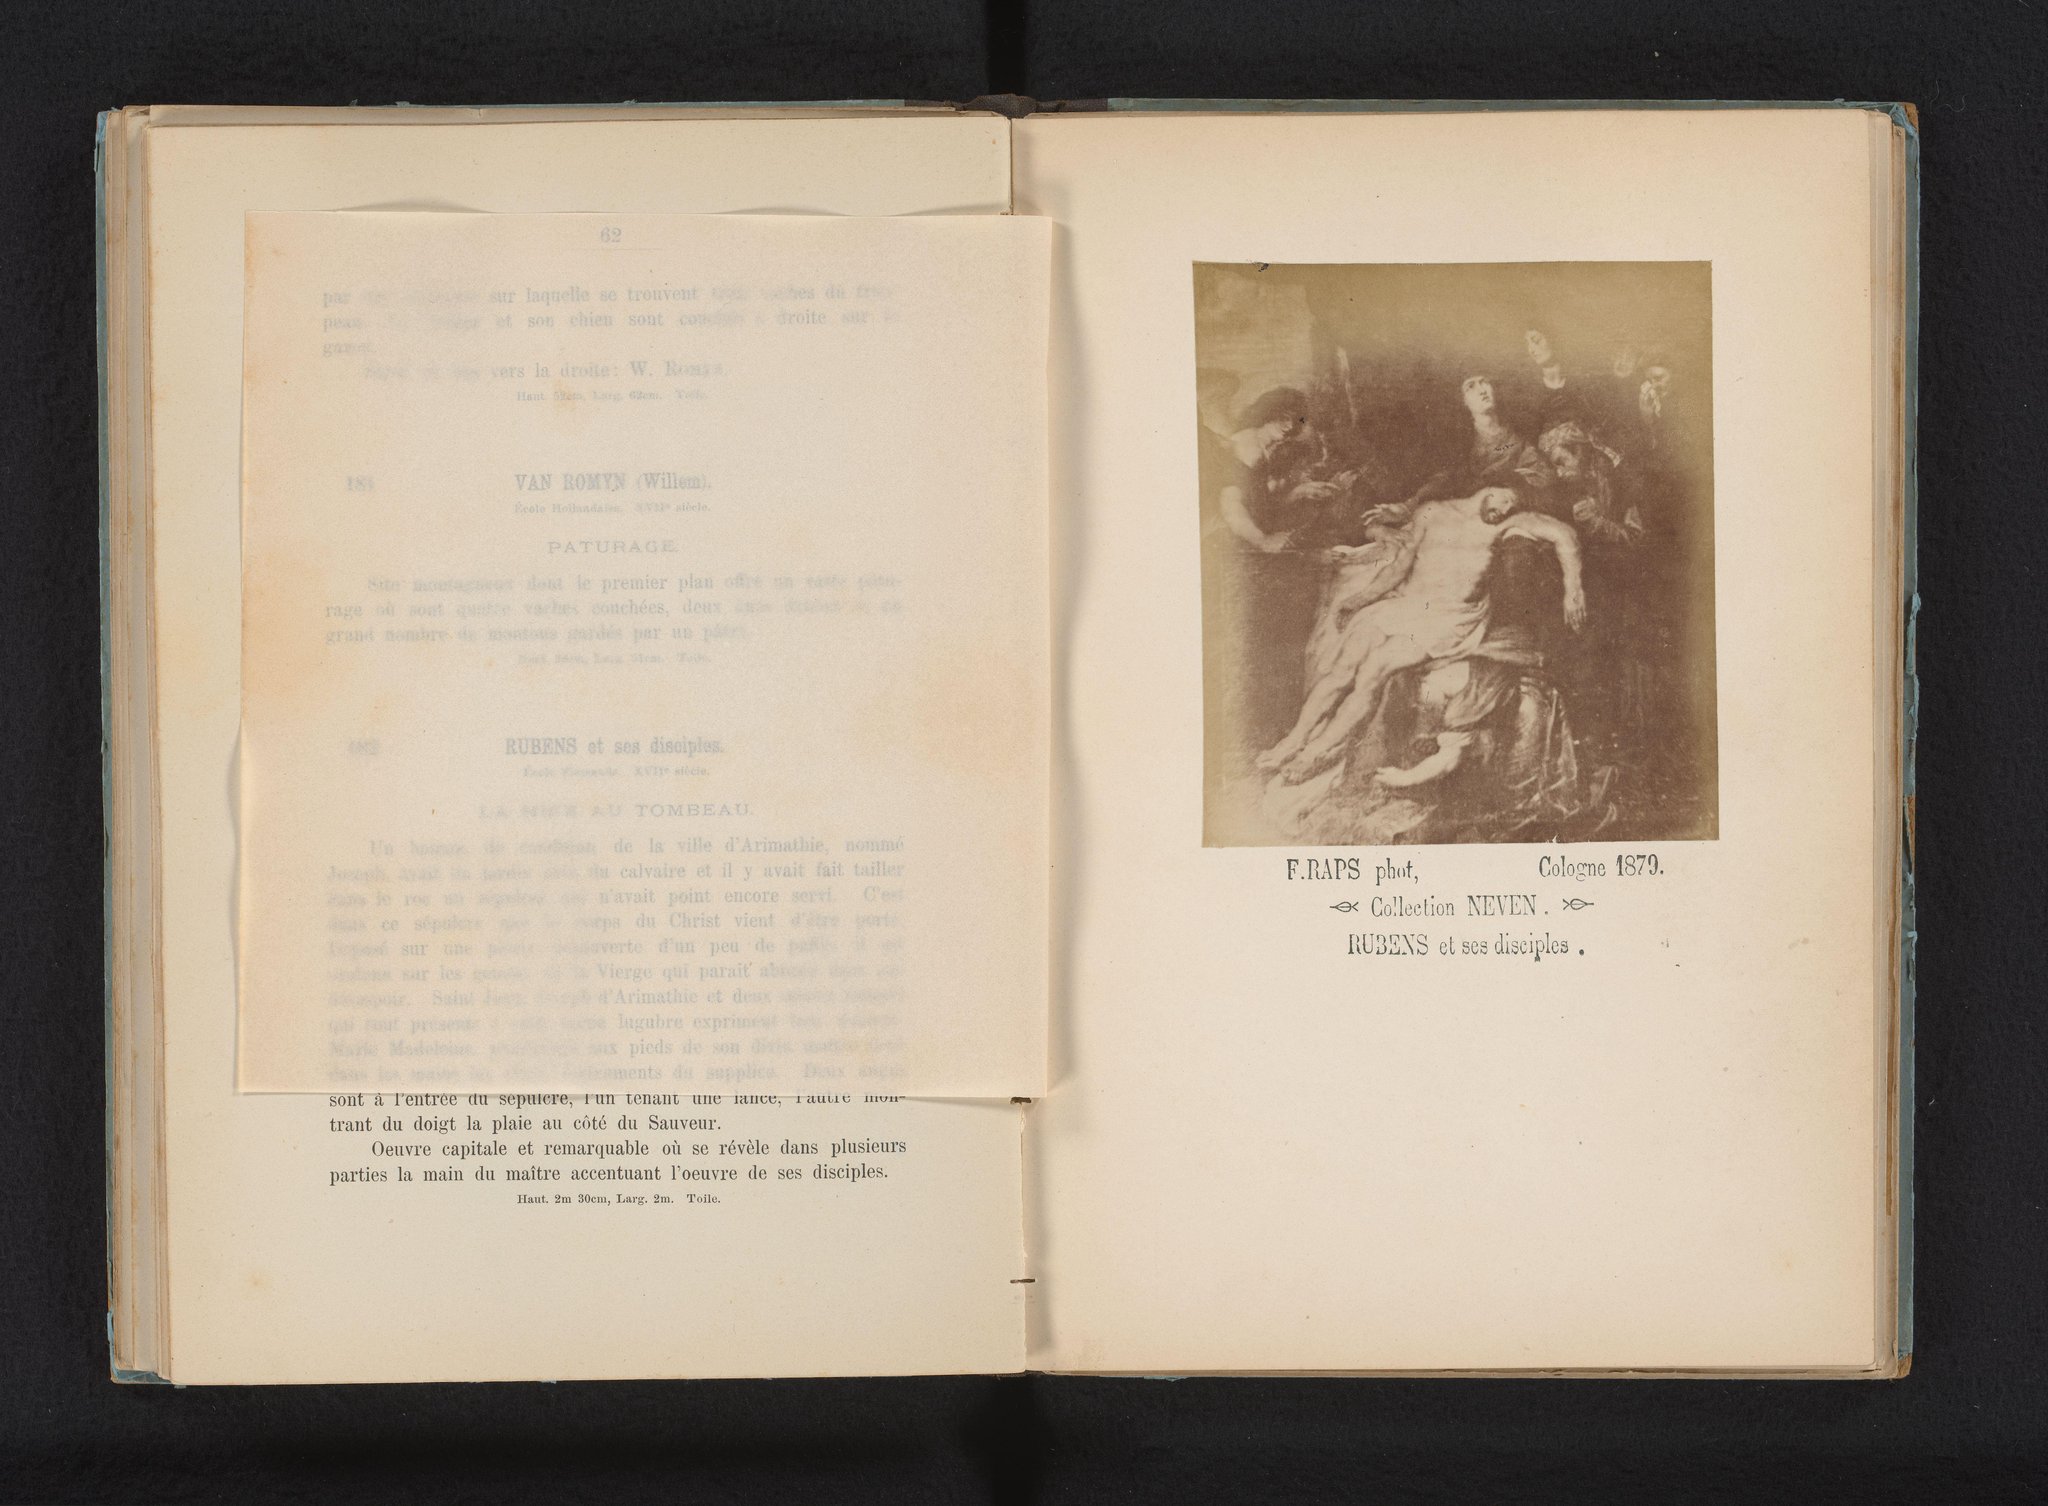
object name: photograph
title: Fotoreproductie van een schilderij van de graflegging van Christus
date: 1879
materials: photographic support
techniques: albumen print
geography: cologne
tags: preparations for christ's entombment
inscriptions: inscription: ‘Collection NEVEN/ Rubens et ses disciples.’